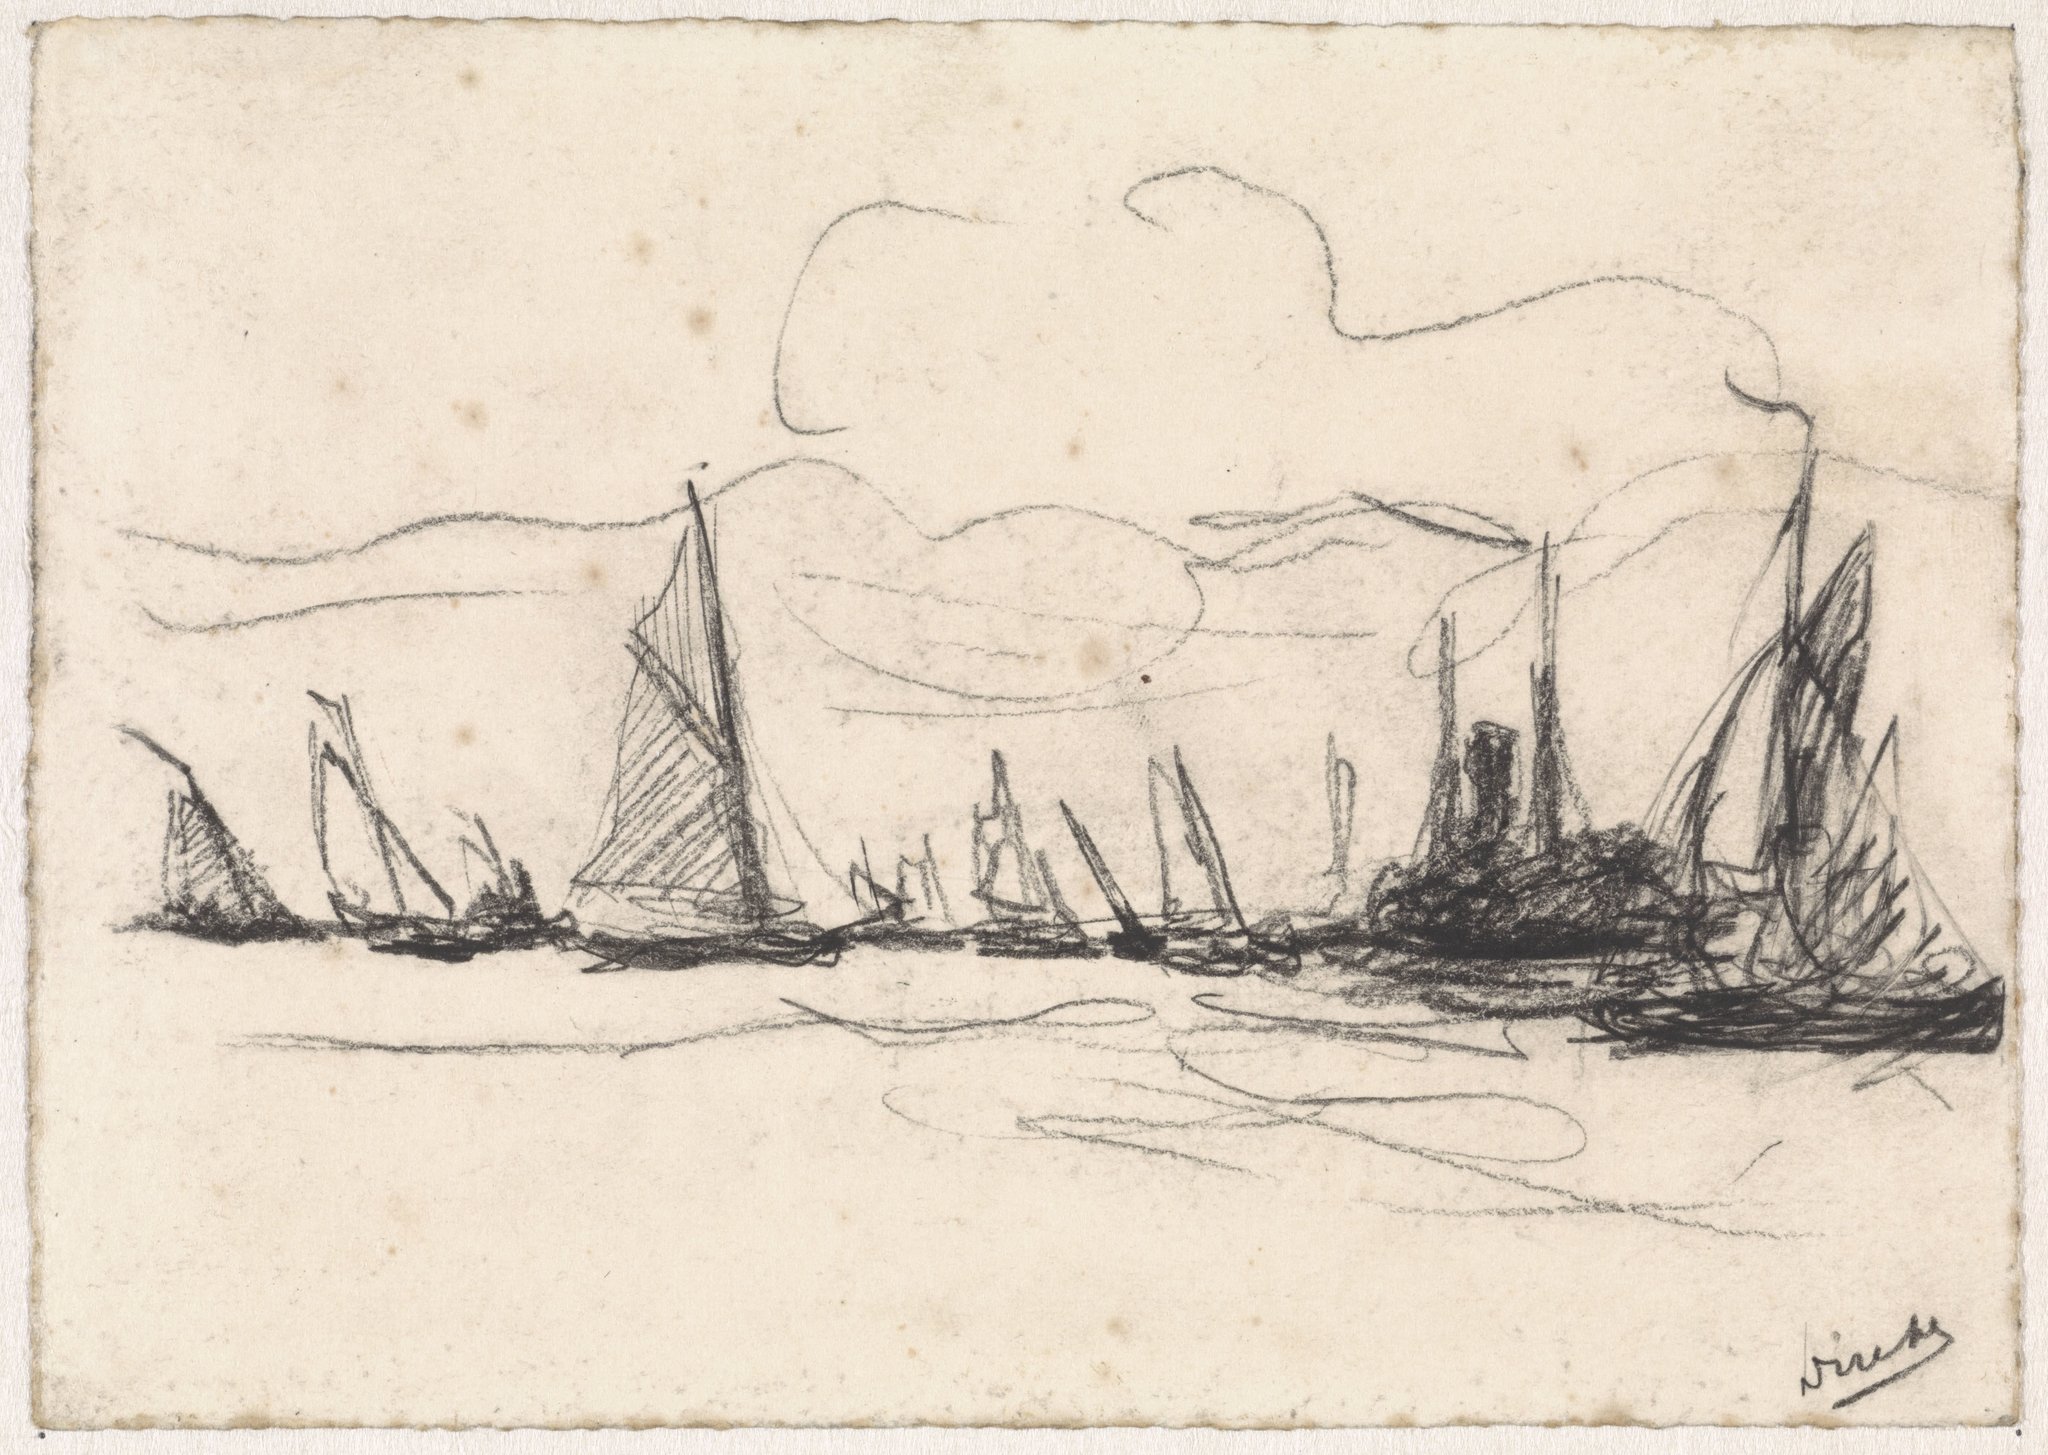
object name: drawing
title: Zeegezicht met zeilboten en een stoomboot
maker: anton dirckx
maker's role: draughtsman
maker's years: 1878-1927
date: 1888-1927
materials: chalk, paper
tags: sailing-ship, sailing-boat, steamship, motorship